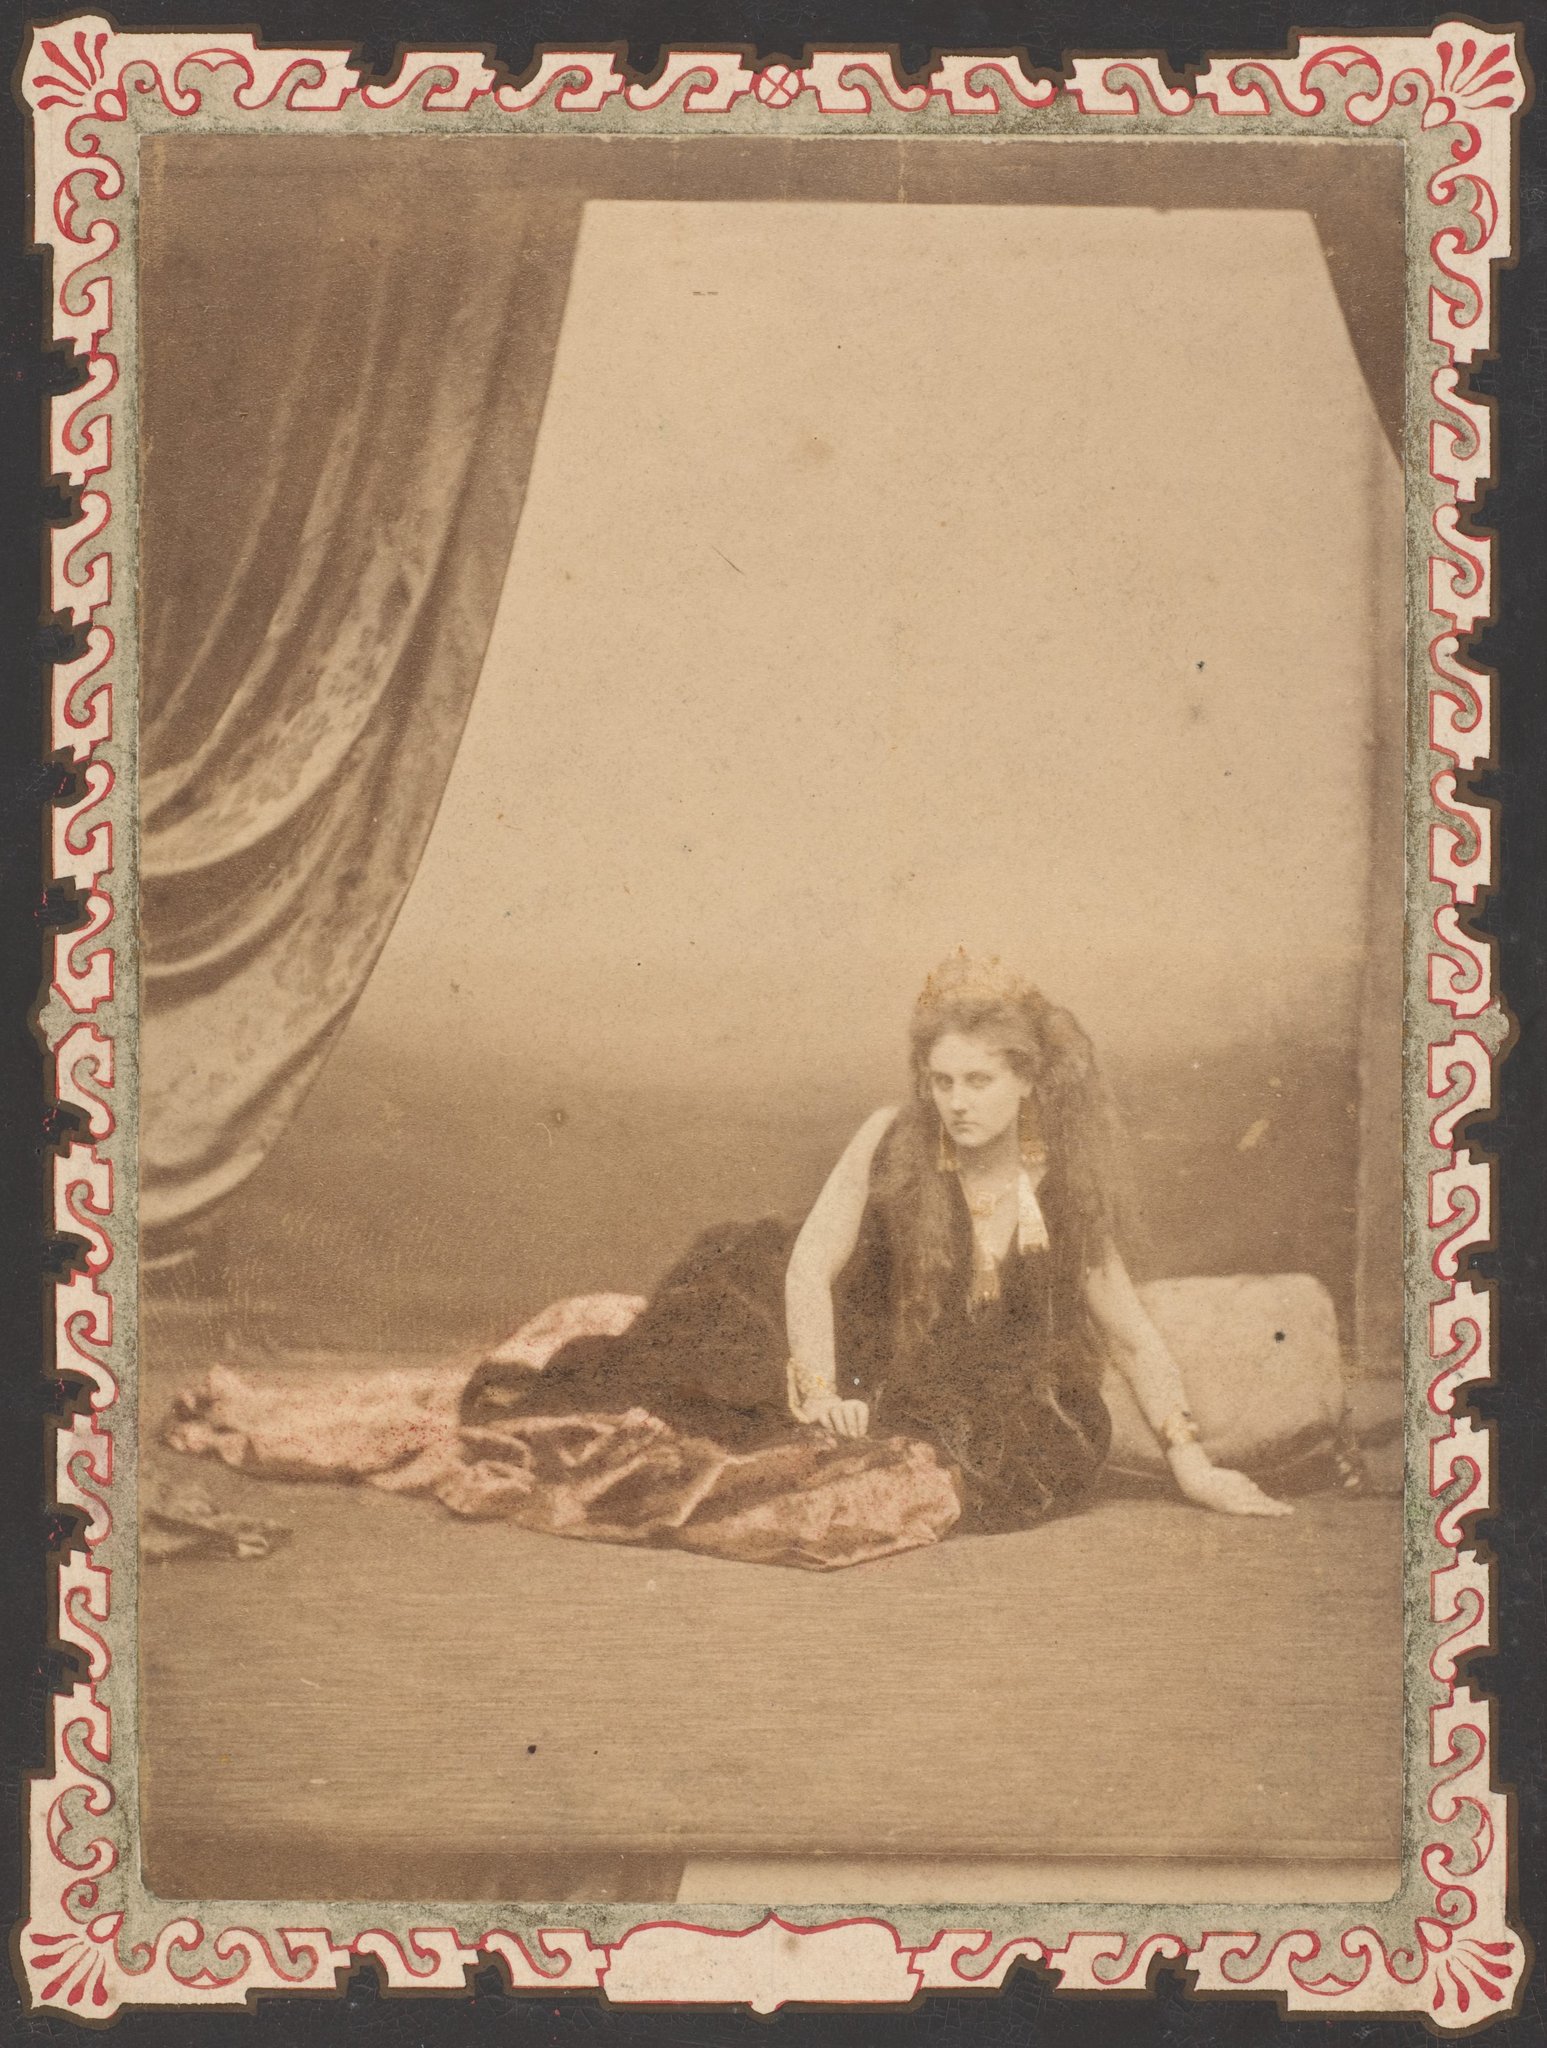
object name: photograph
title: [Reine d'Etrurie]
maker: pierre-louis pierson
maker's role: artist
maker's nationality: french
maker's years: 1822-1913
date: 1860-1869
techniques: albumen silver print, glass negative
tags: portraits,women